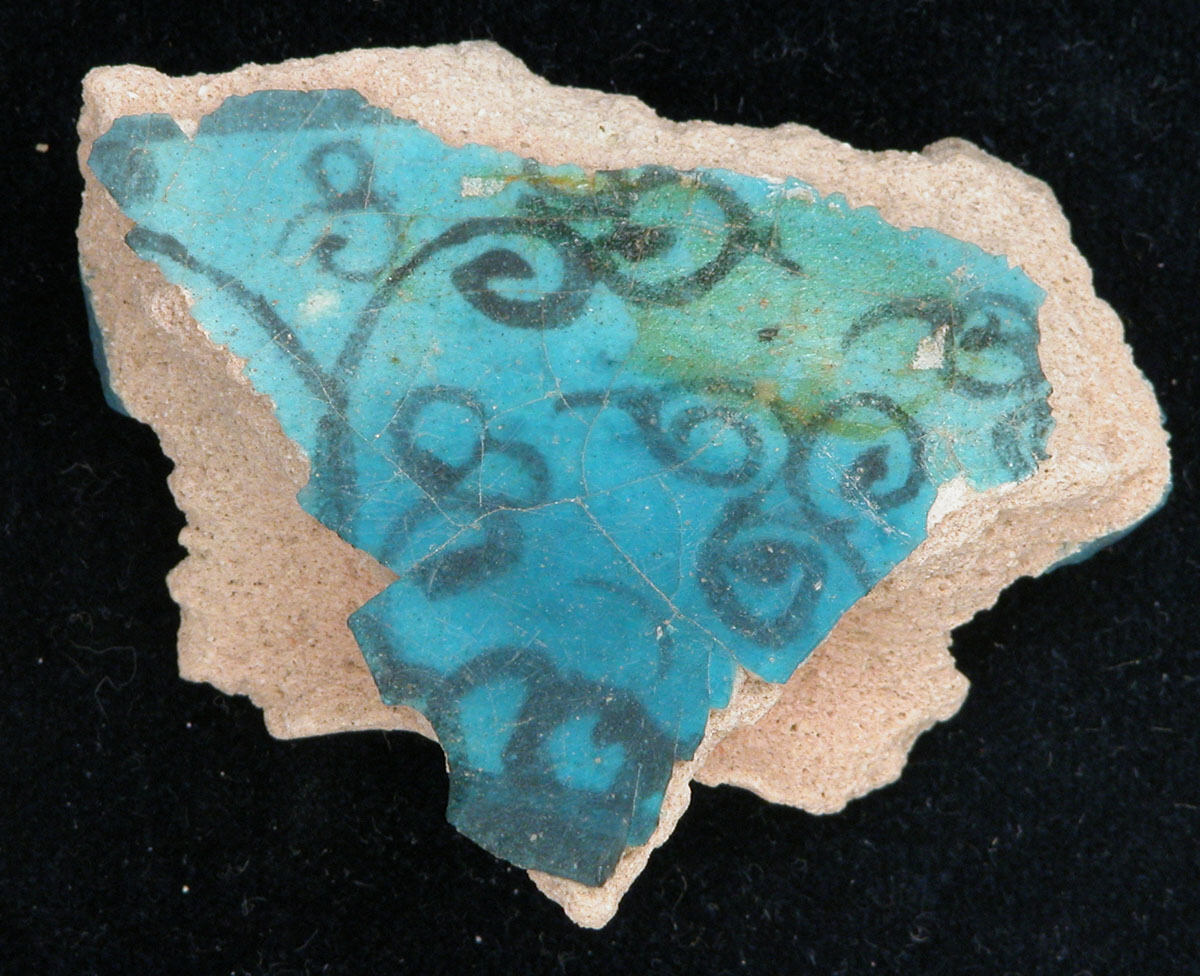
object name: fragment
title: Ceramic Fragment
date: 1101-1300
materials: stonepaste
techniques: painting, underglaze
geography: saudi arabia